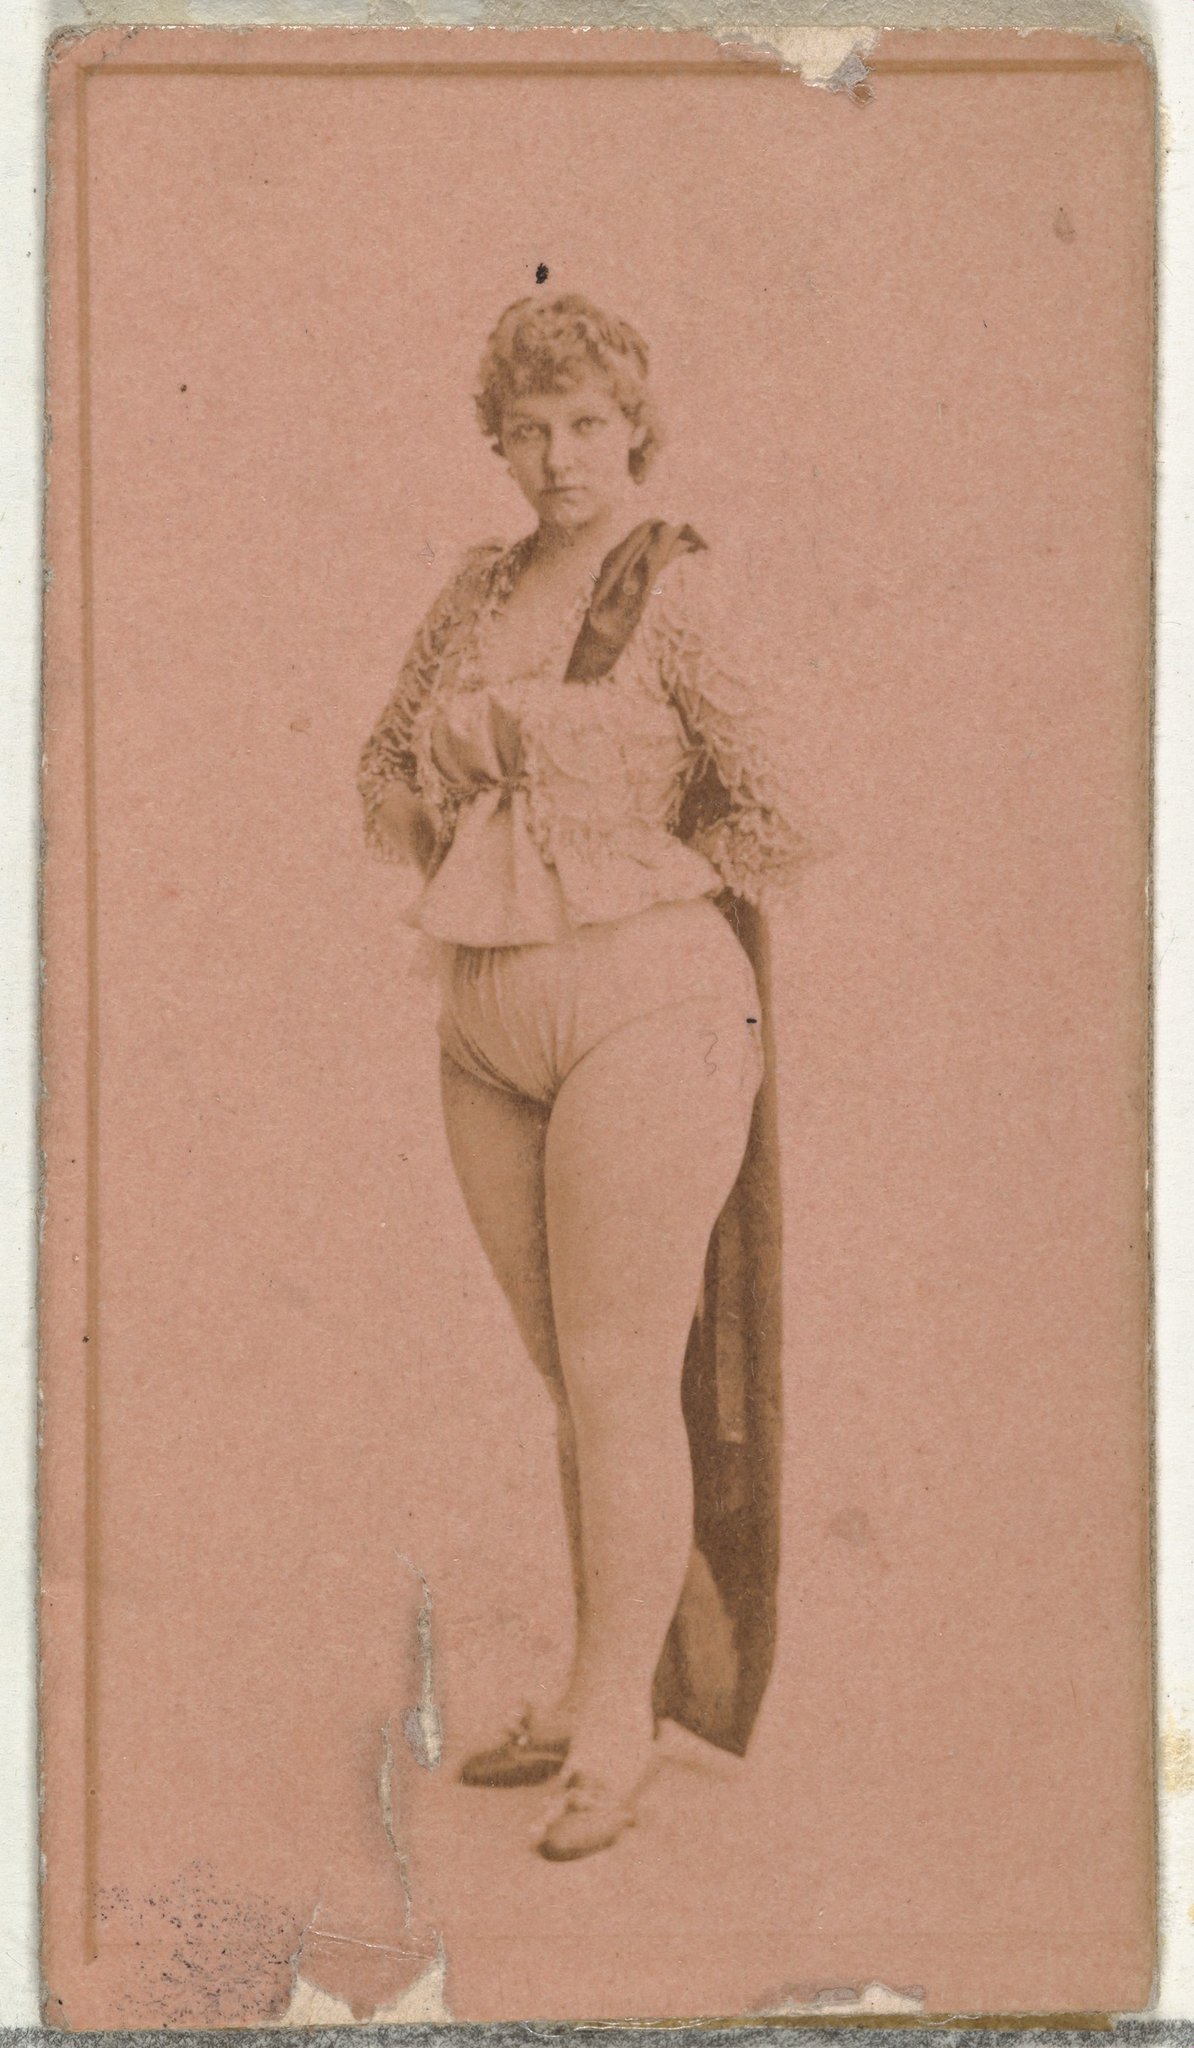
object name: photograph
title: [Actress standing in long cape], from the Actors and Actresses series (N145-8) issued by Duke Sons & Co. to promote Duke Cigarettes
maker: w. duke, sons & co.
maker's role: publisher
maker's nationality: american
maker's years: 1870-1920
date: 1891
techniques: albumen silver print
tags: portraits,women,actresses